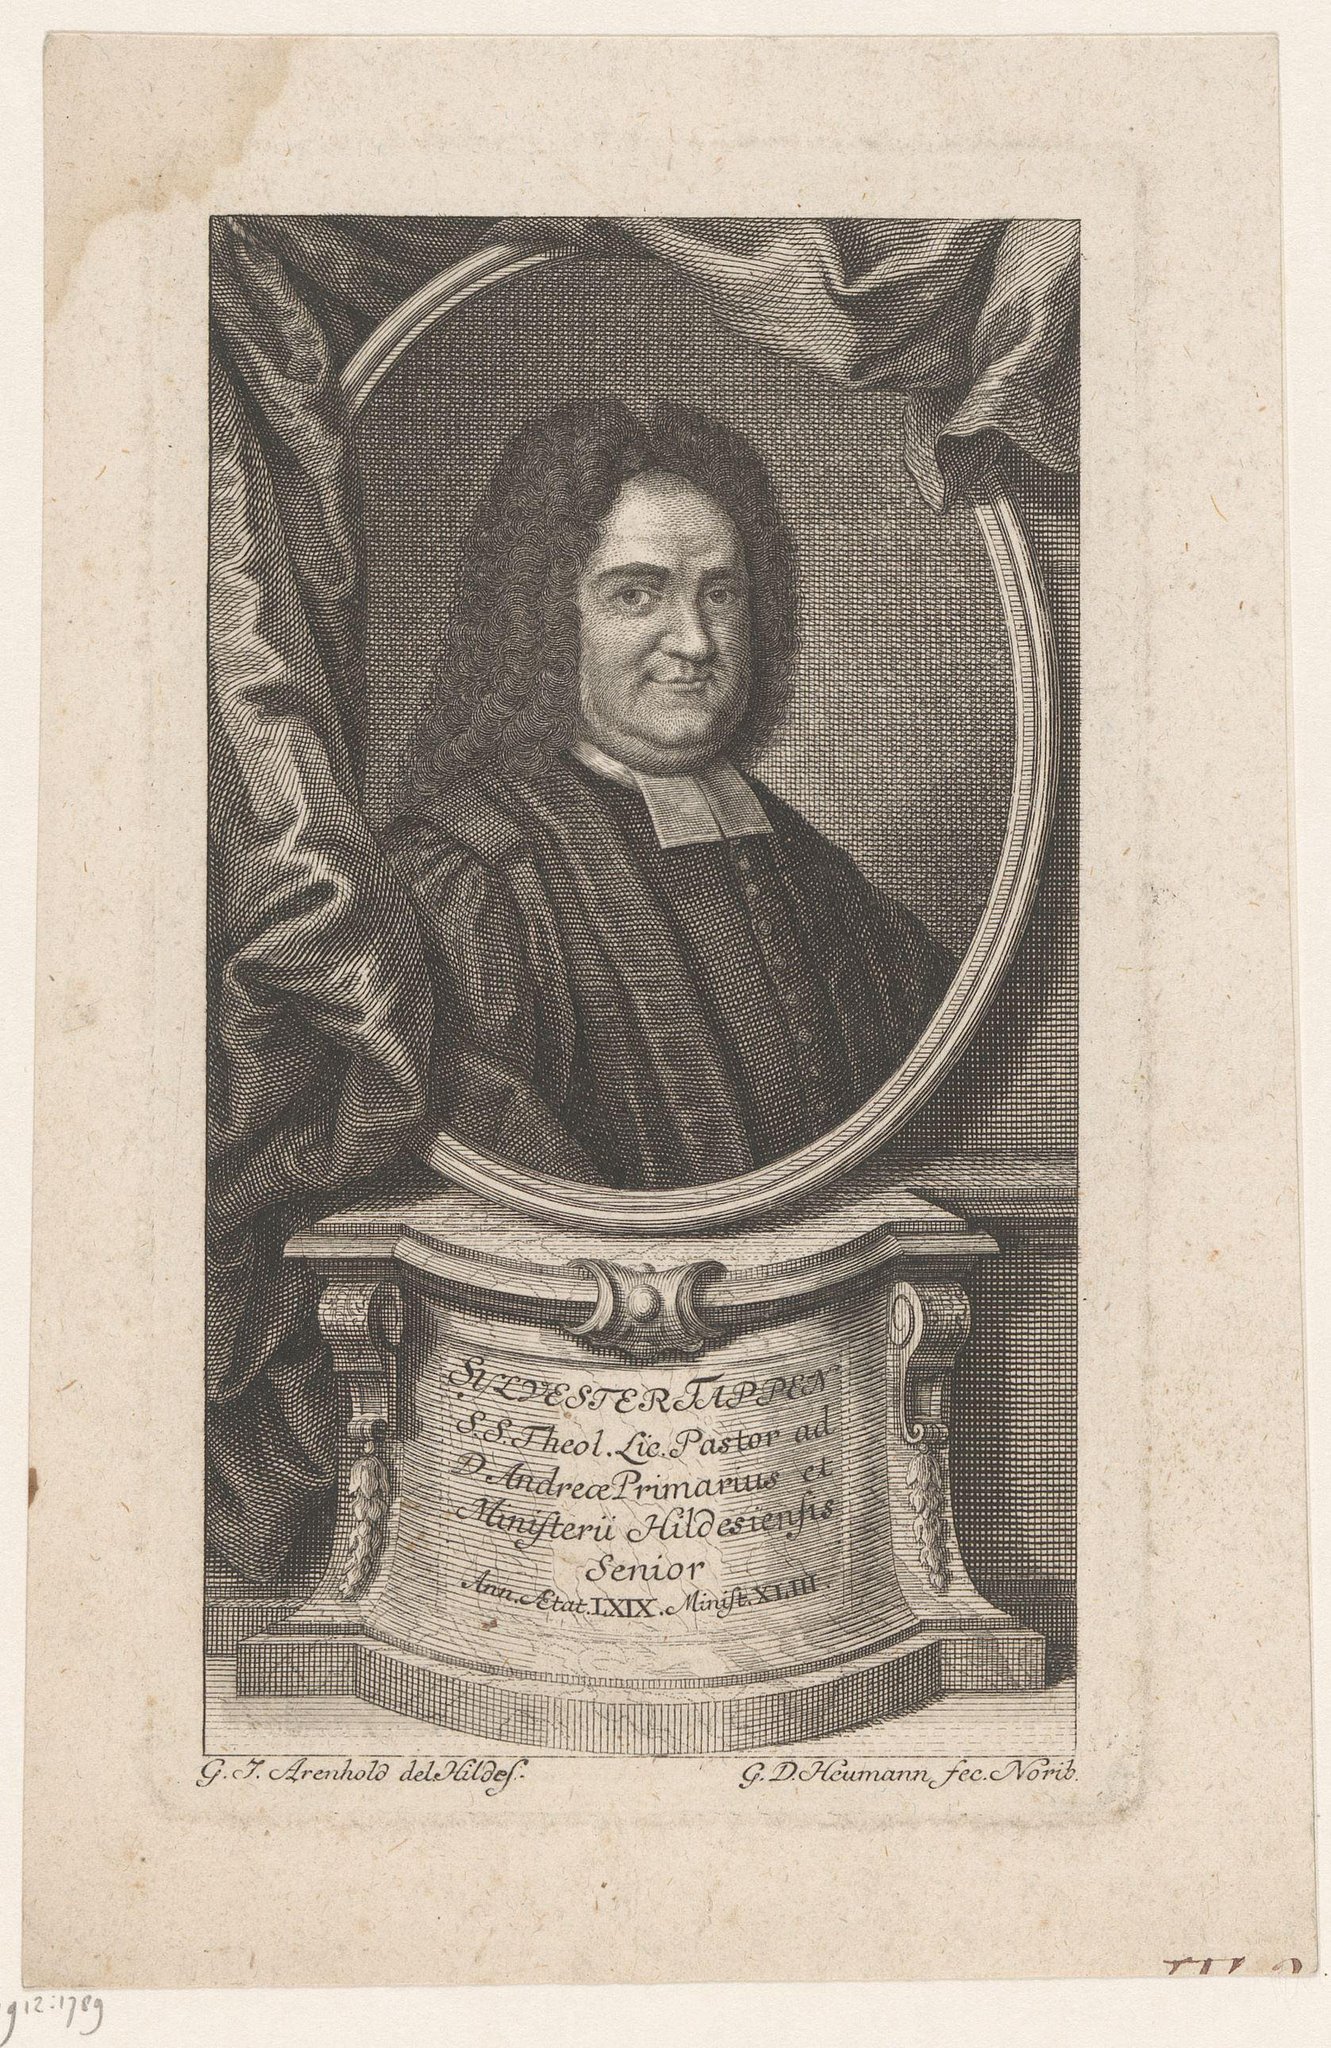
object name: print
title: Portret van Sylvester Tappe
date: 1701-1759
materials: paper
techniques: engraving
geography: nuremberg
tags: historical persons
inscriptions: collector's mark: Lugt 2228